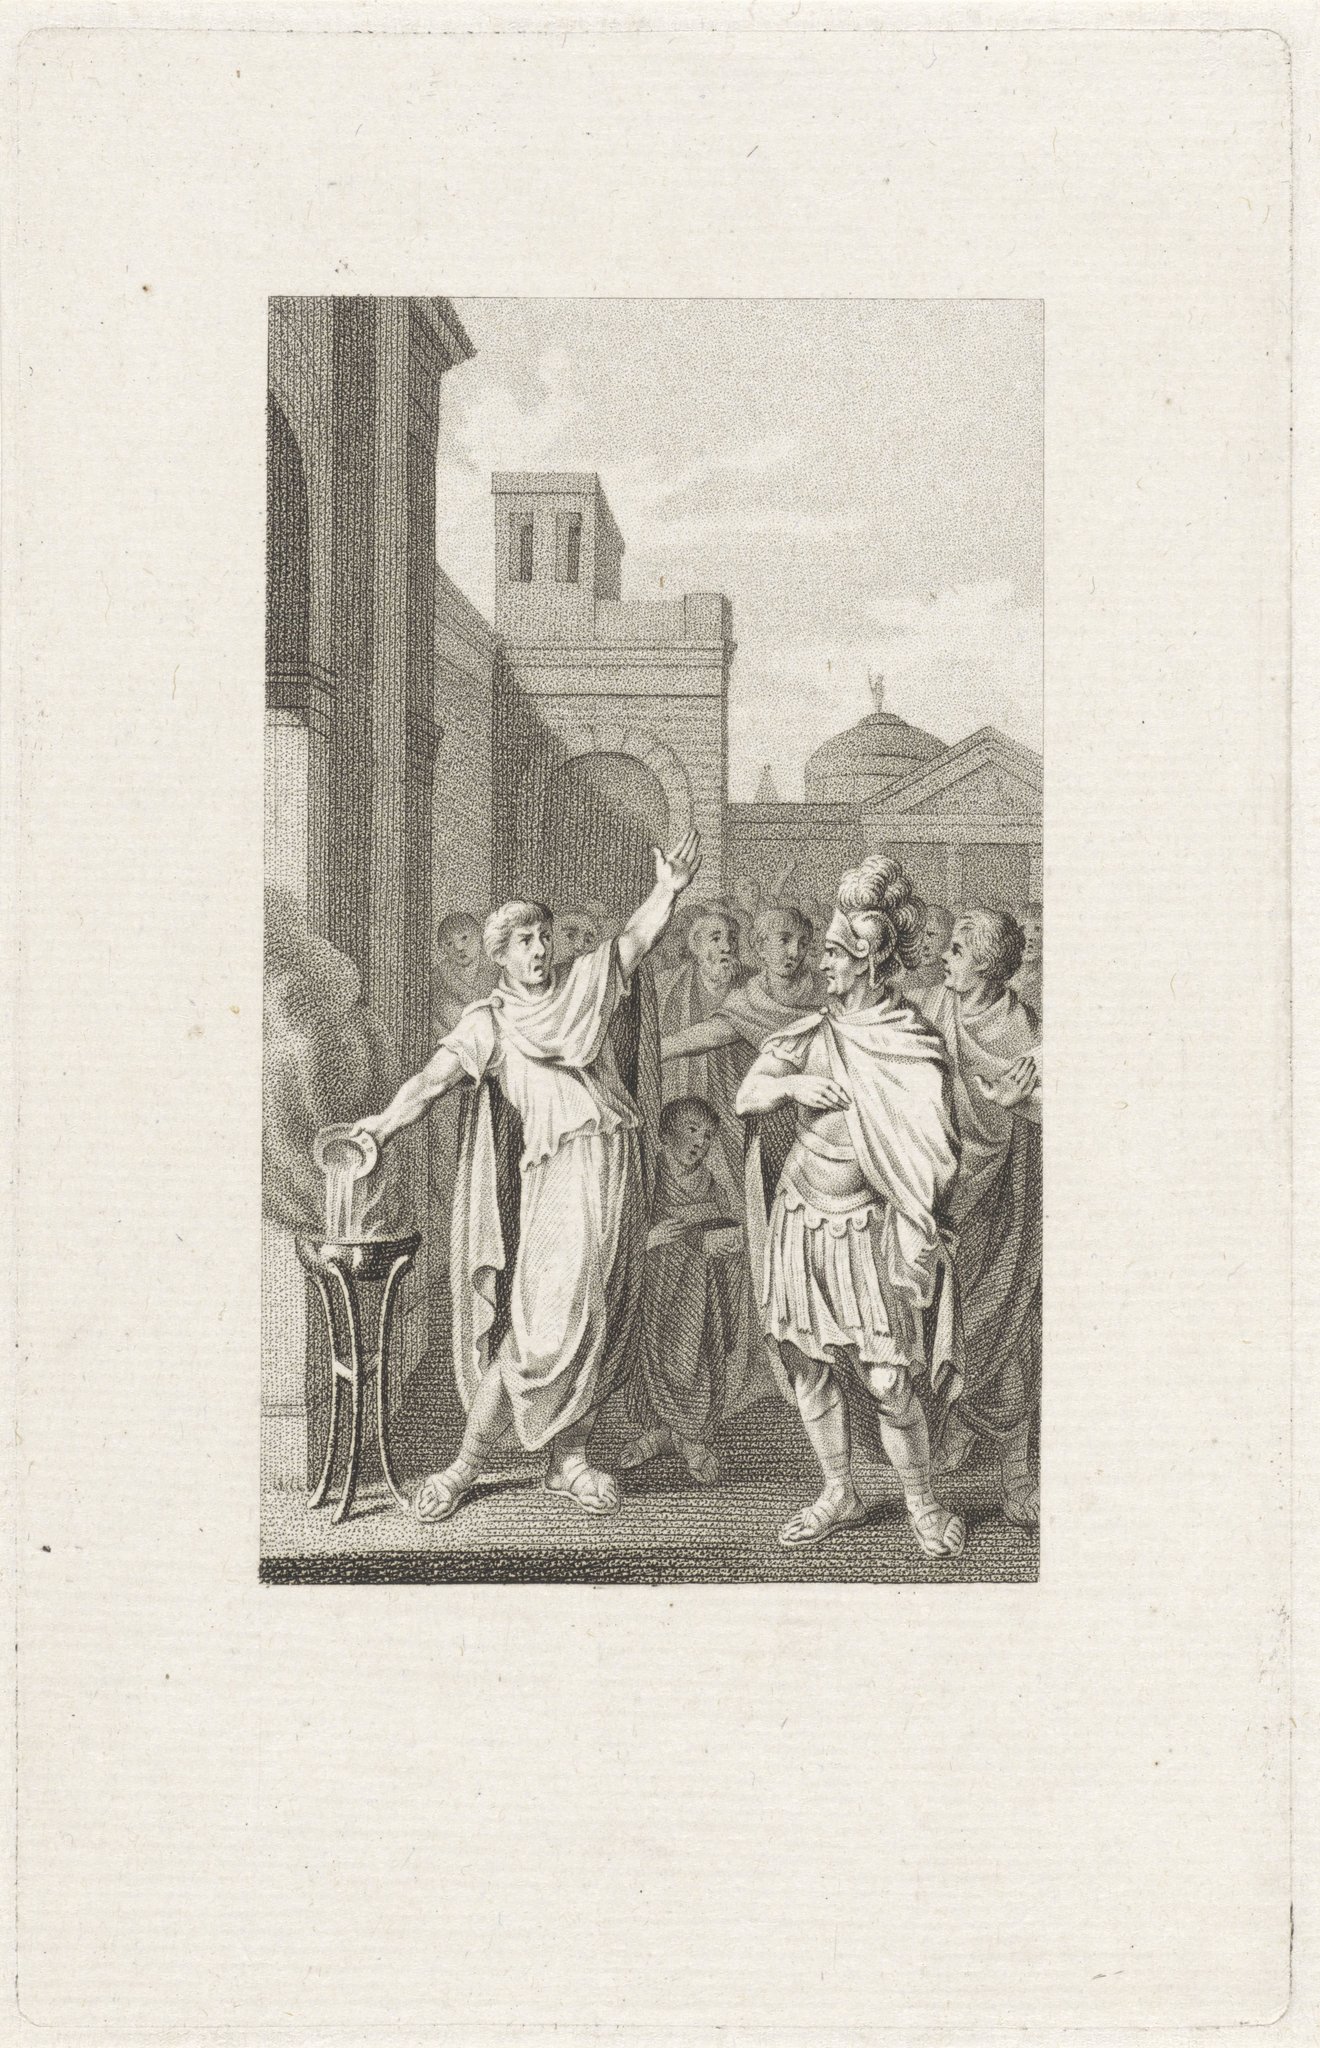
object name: print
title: Marcus Licinius Crassus verlaat Rome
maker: ludwig gottlieb portman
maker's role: print maker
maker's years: 1772-1828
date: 1800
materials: paper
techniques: stippled etching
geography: amsterdam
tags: (story of) m. licinius crassus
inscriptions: collector's mark: Lugt 2228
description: Definitieve staat van deze prent gebruikt als illustratie in: Stuart, Martinus. Romeinsche geschiedenissen, deel XVI, p. 36. Amsterdam: Johannes Allart, 1800.